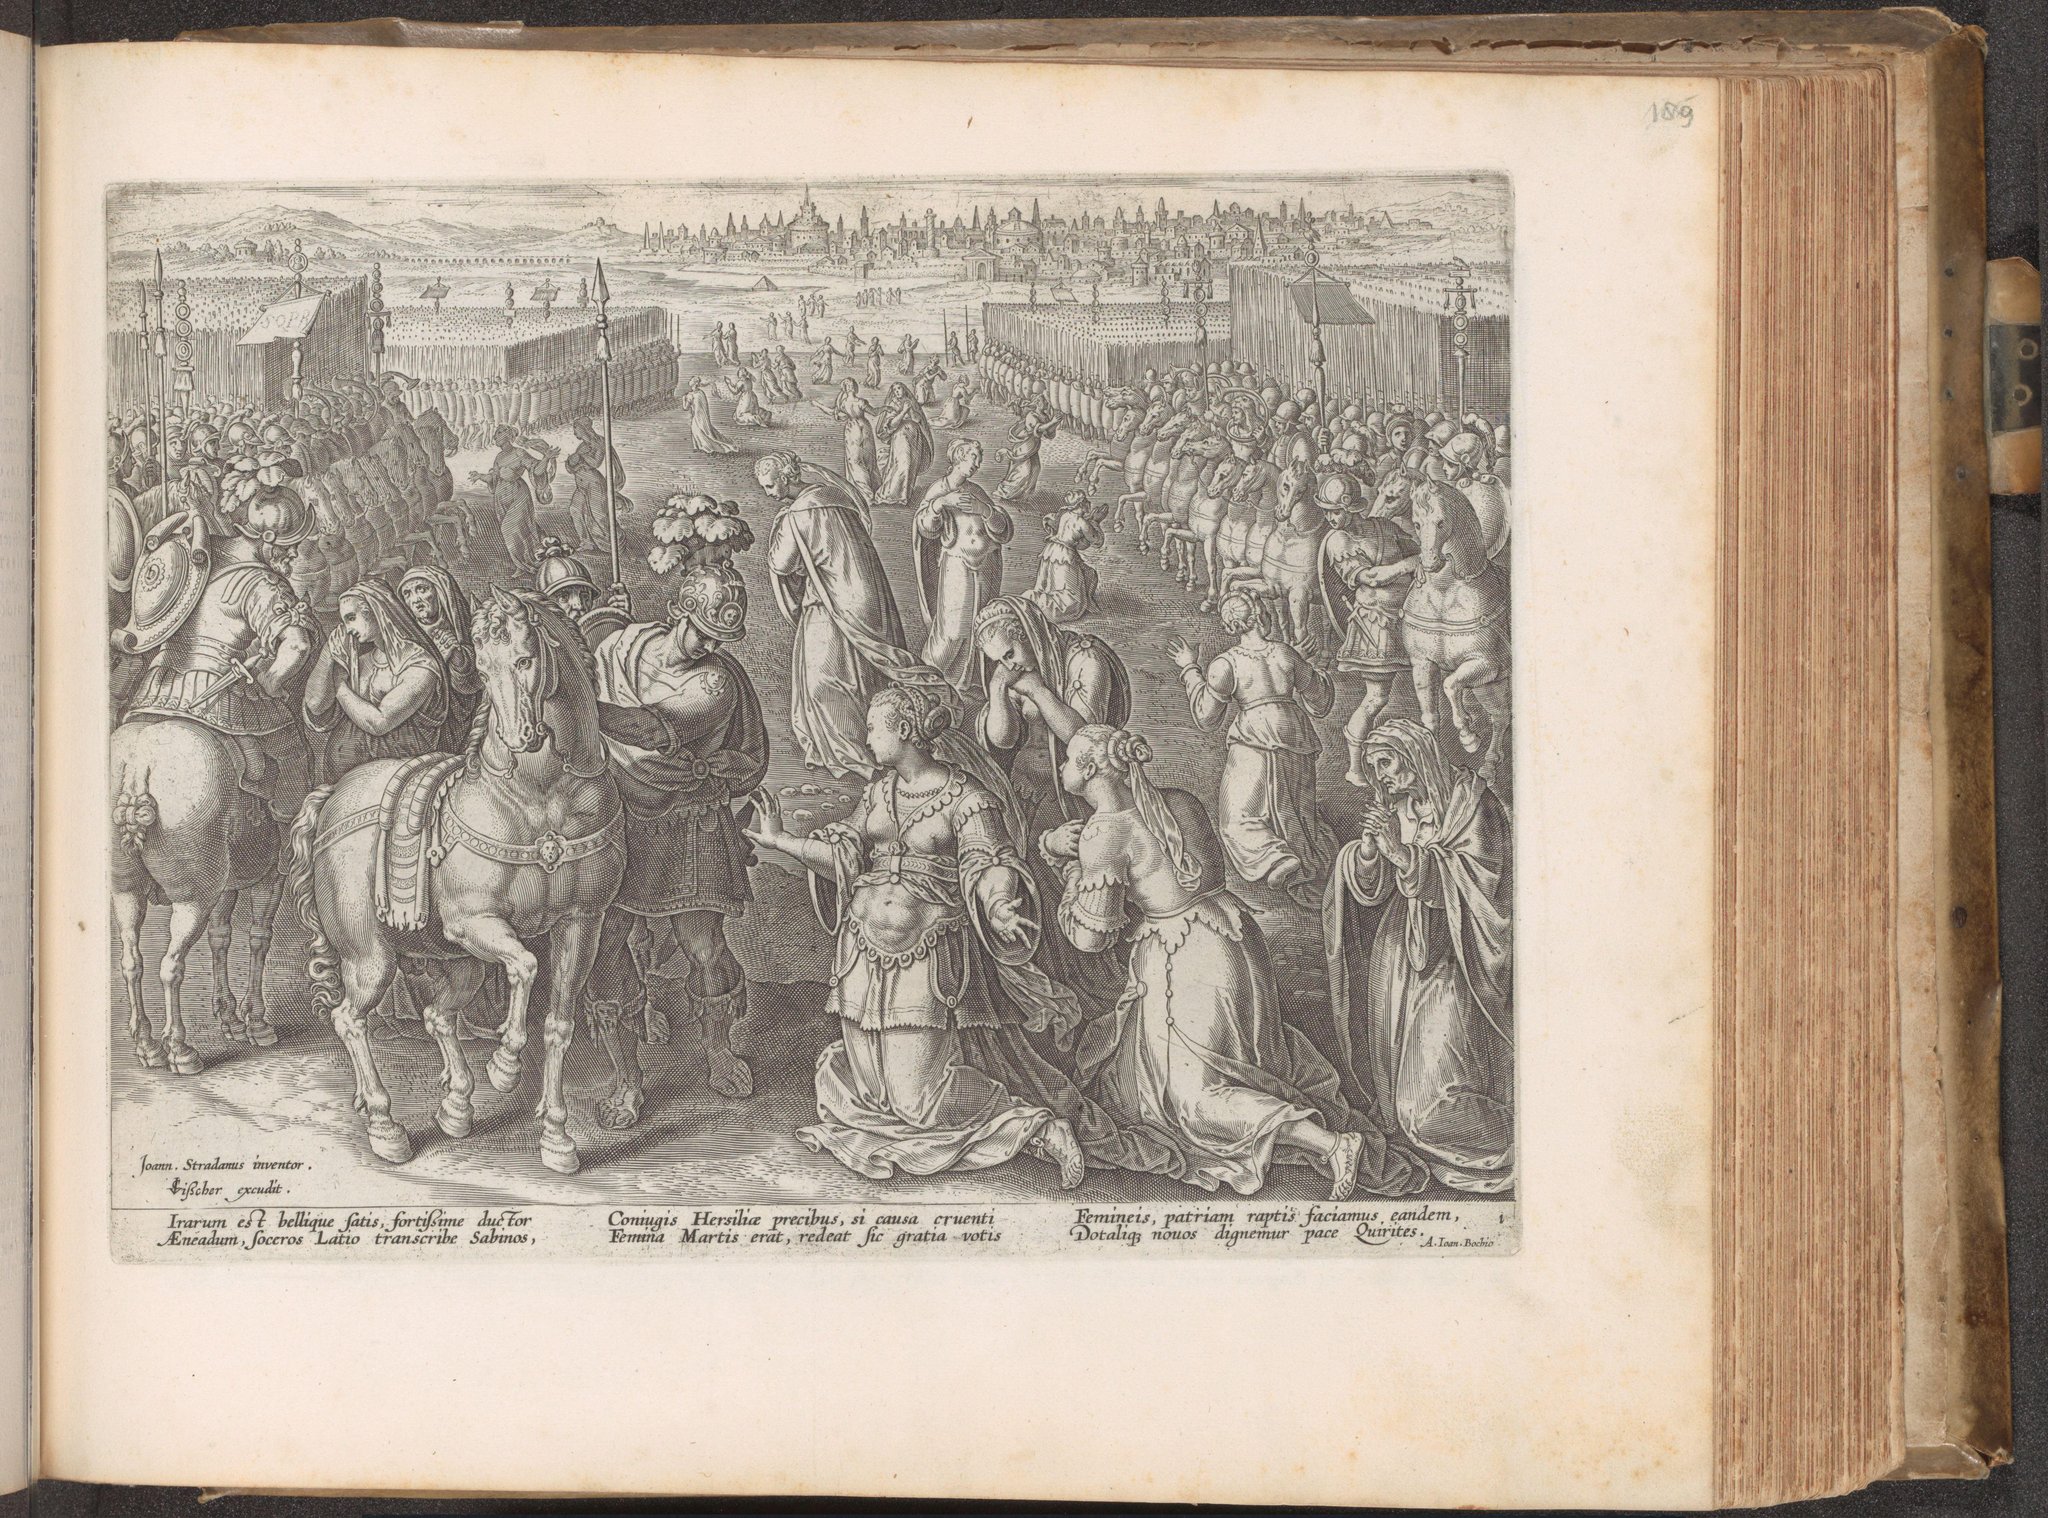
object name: album leaf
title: Verzoening tussen de Romeinen en de Sabijnen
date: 1653-1654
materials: paper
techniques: engraving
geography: antwerp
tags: reconciliation of the sabines and the romans: the women, some holding their babies, others with their hair loose, and possibly encouraged by hersilia call for peace in the midst of the two fighting armies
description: De moeders van de Sabijnse maagden werpen zich tussen de twee vechtende legers van Sabijnen en Romeinen en doen een oproep tot vrede. Met een onderschrift in drie kolommen in het Latijn. De prent maakt deel uit van een album.